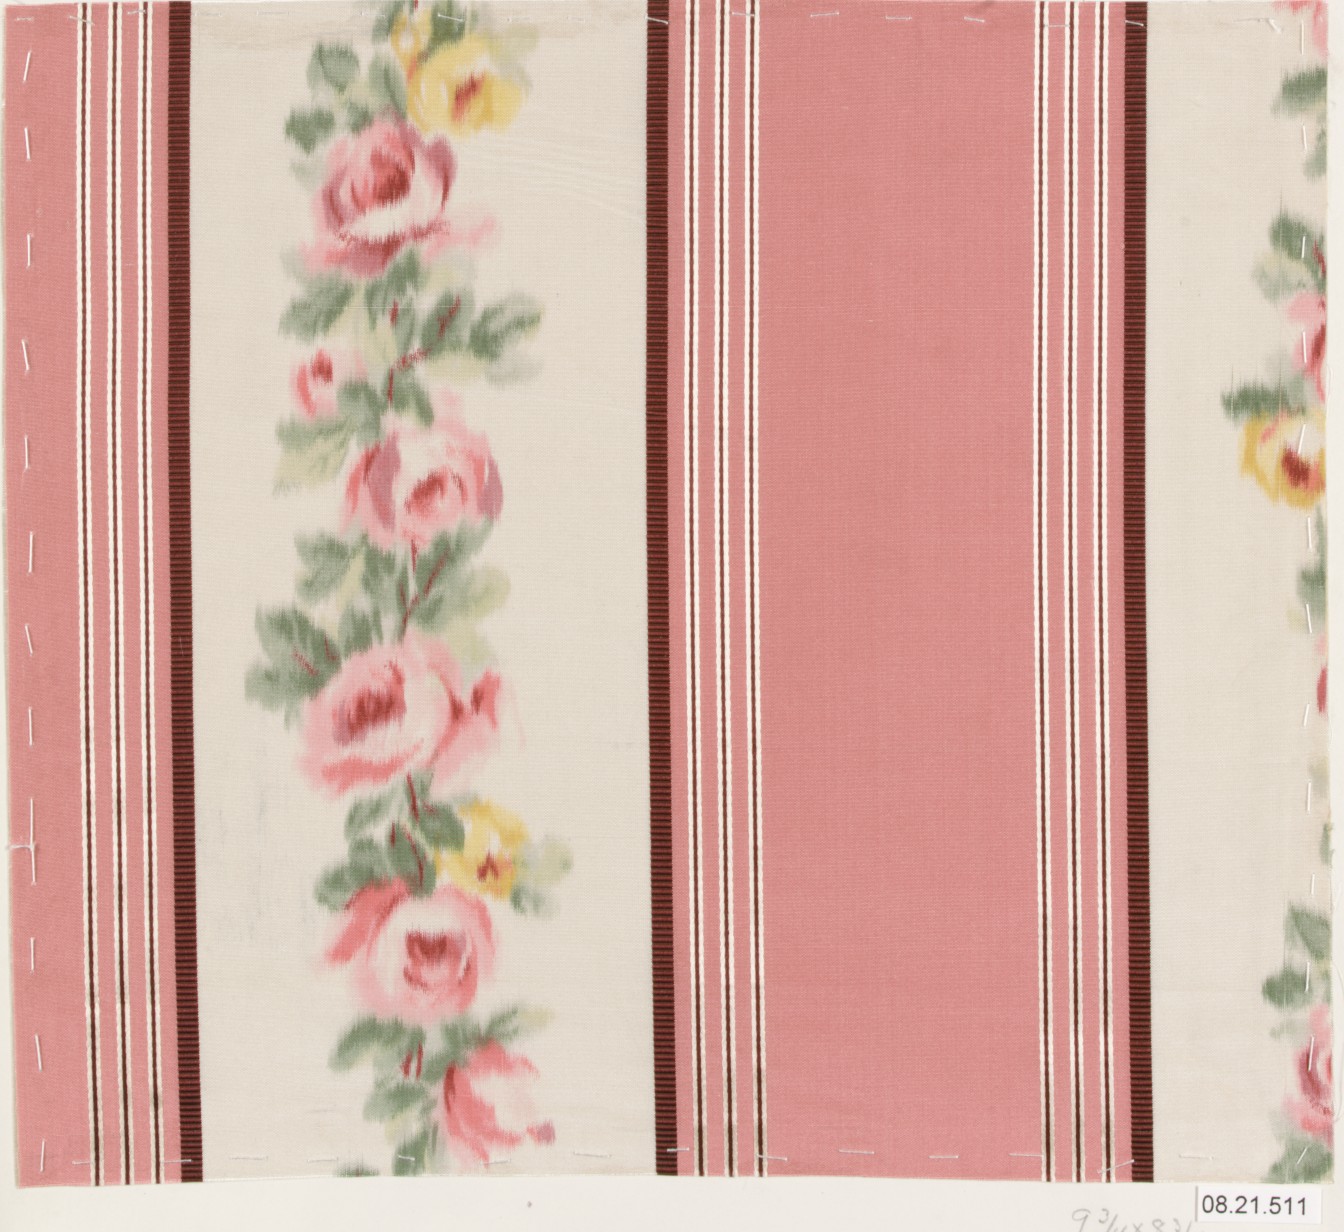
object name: textile sample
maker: Anonymous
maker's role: designer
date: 1900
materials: silk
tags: roses